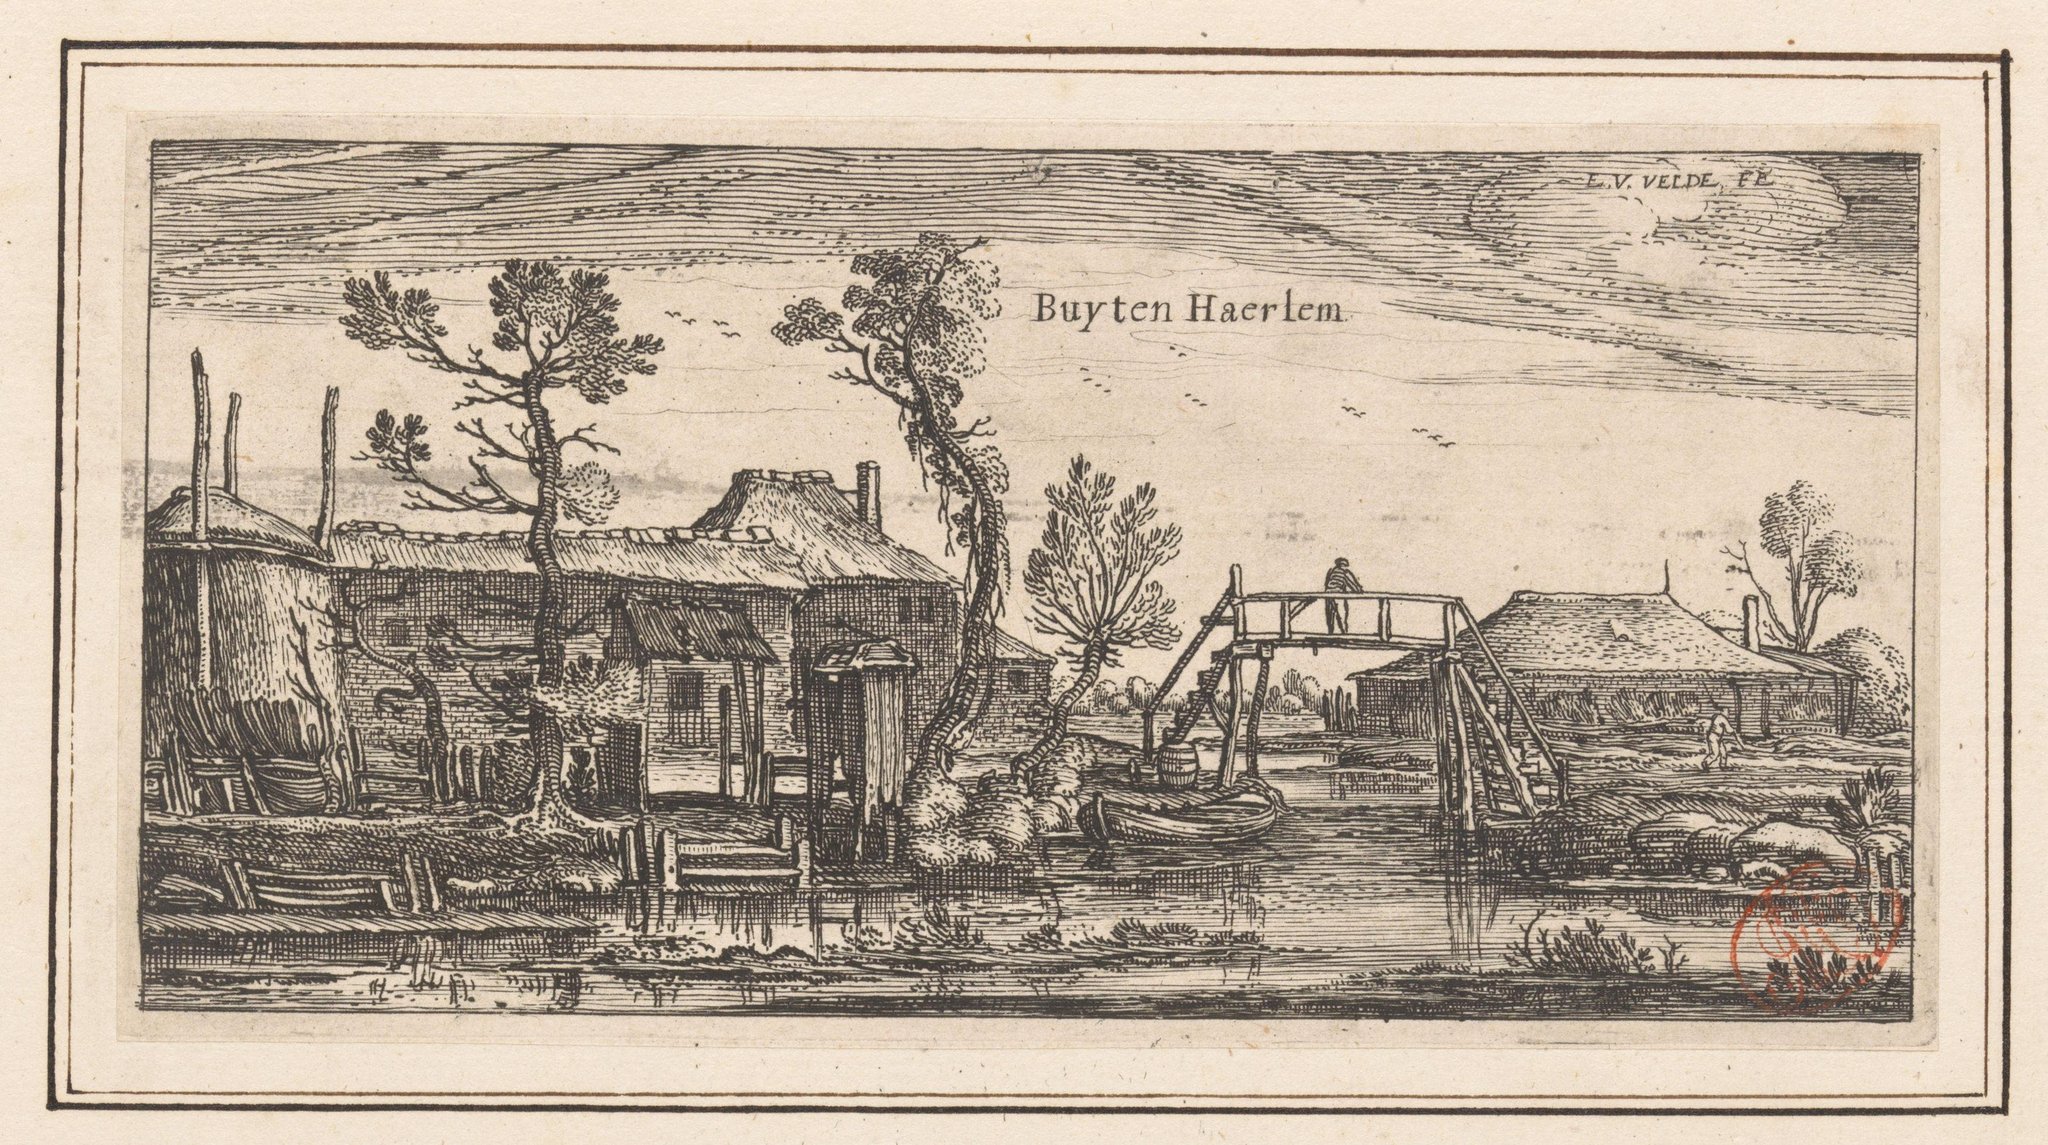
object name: print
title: Landschappen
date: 1615-1616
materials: paper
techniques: engraving, etching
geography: haarlem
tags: farm or solitary house in landscape, haarlem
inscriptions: collector's mark: Lugt 195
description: Deze prentserie werd voor het eerst uitgegeven door Johannes Pietersz. Berendrecht, in 1615-1616. De huidige prent komt uit de serie die later, tussen 1710 en 1747, werd uitgegeven door Leonardus Schenk onder de titel ‘10 Lantschappen nae t'leven geteeckent’.